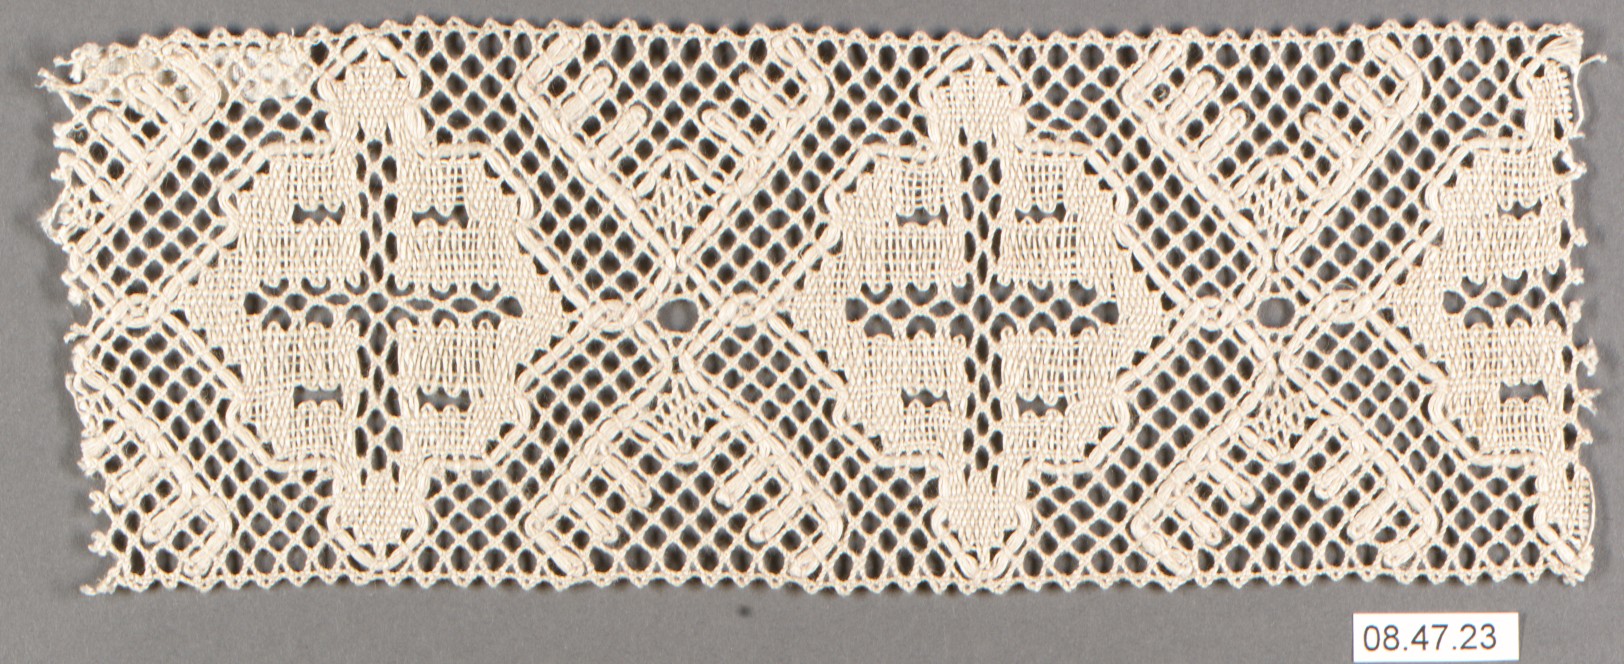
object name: fragment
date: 1801-1900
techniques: lace